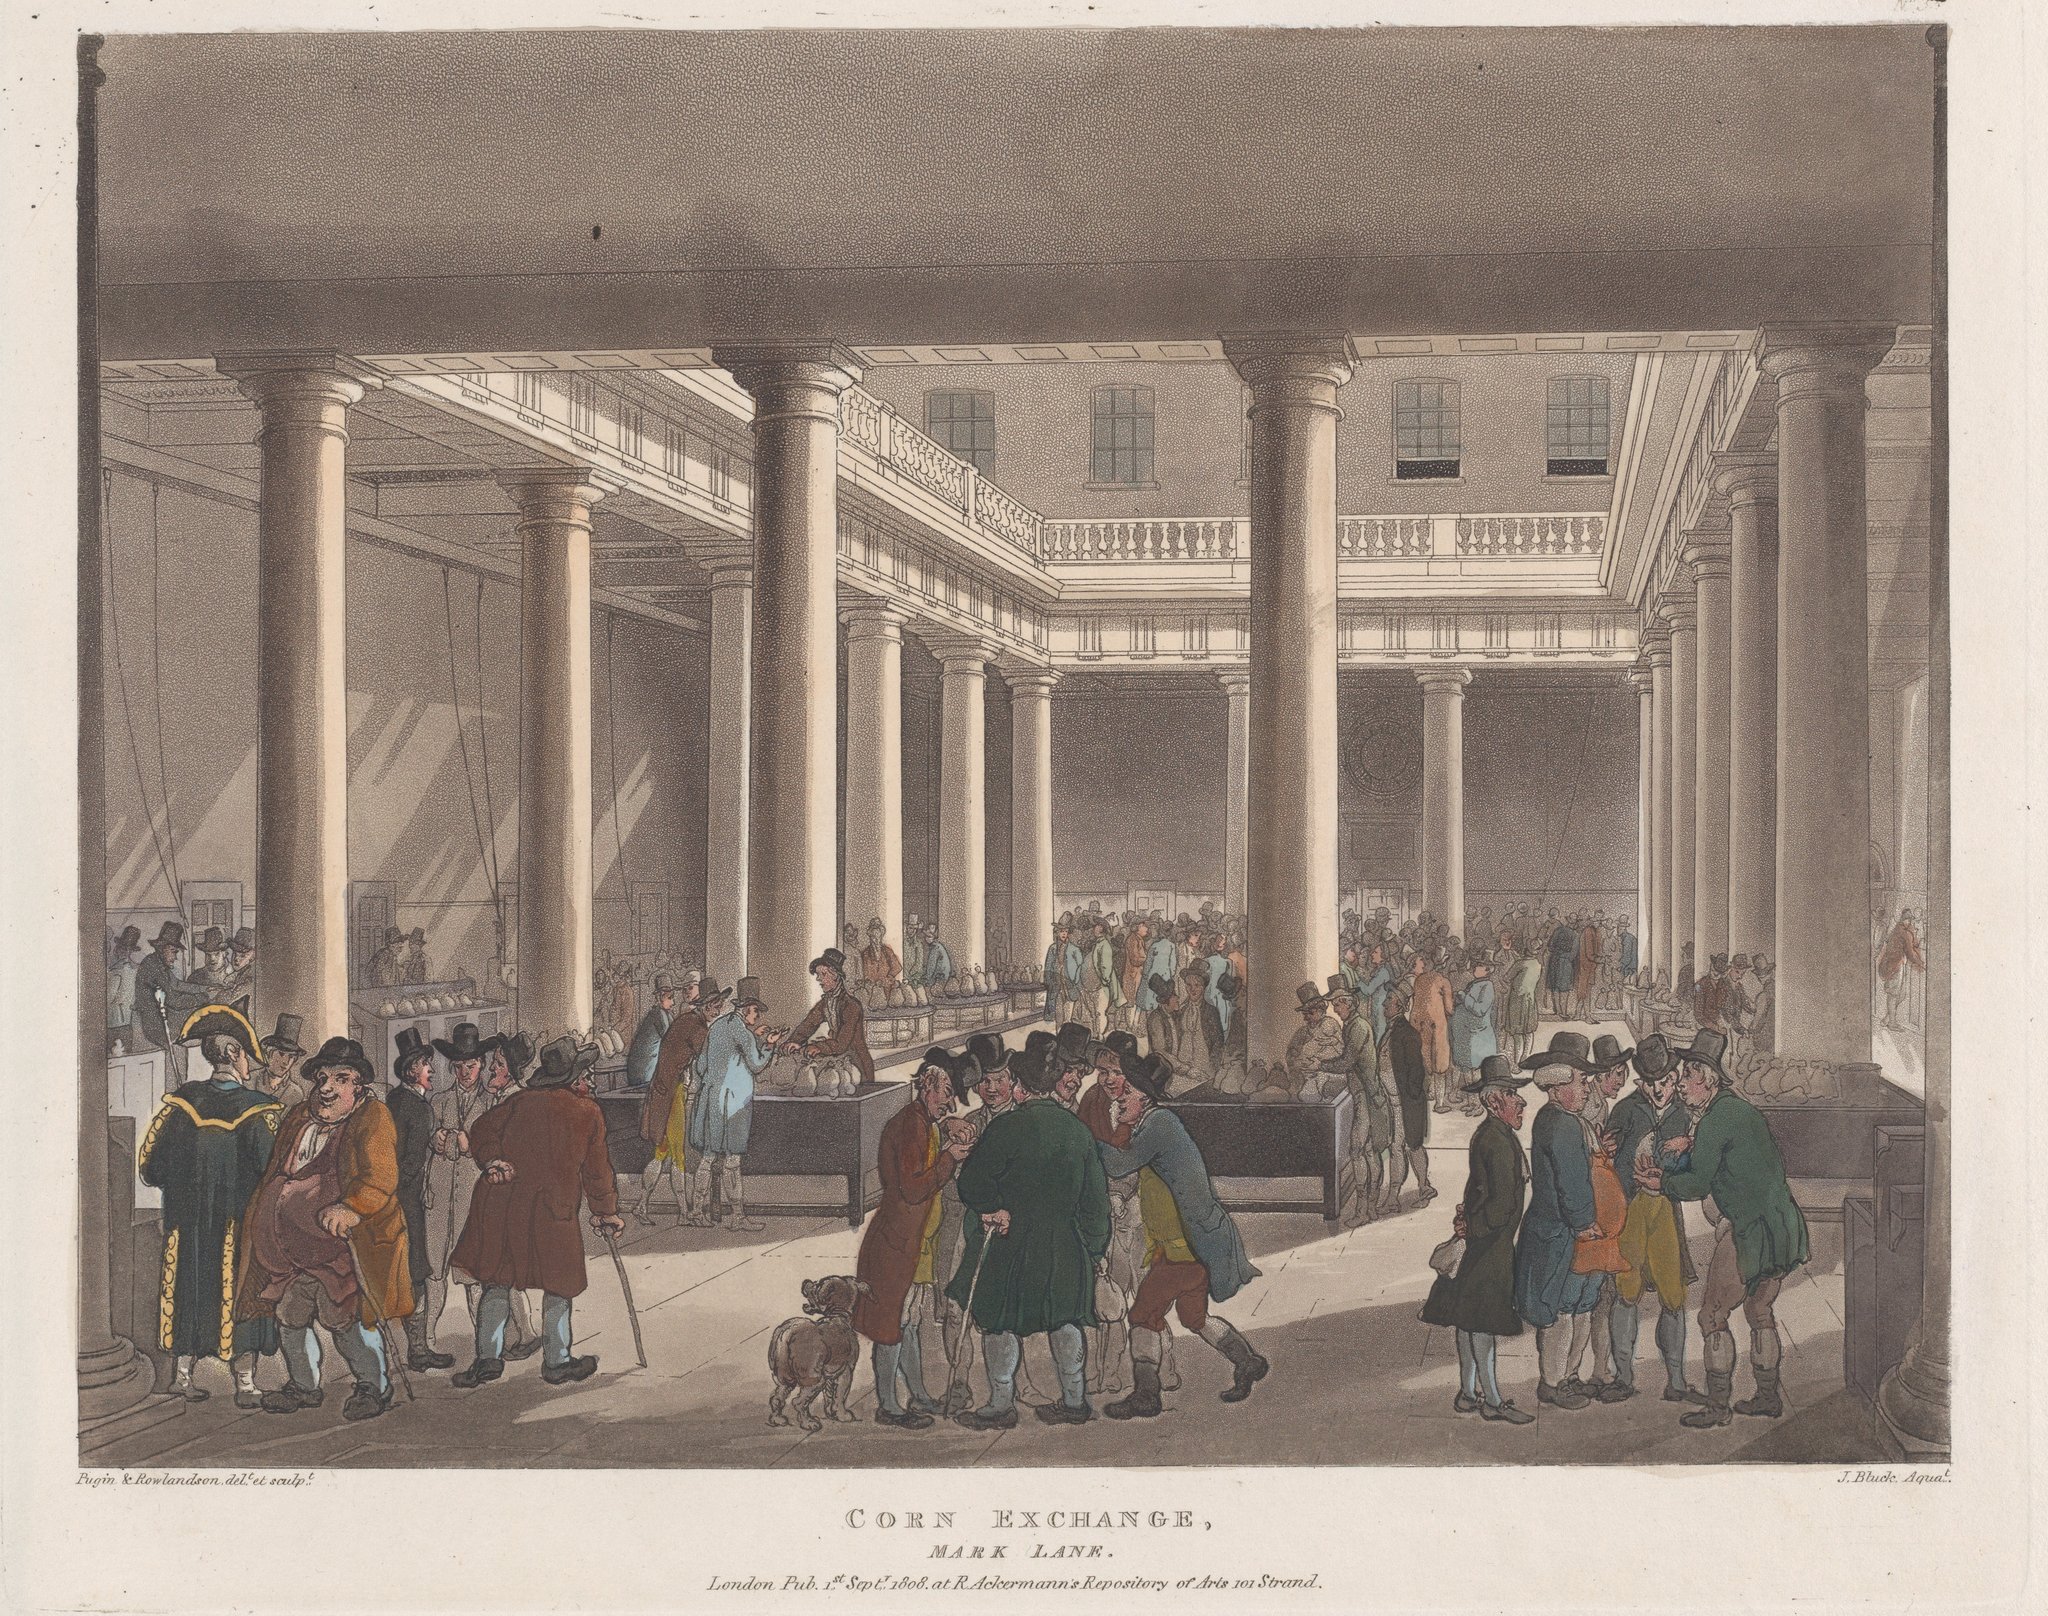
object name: print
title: Corn Exchange, Mark Lane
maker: thomas rowlandson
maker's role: artist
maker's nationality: british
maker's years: 1757-1827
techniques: aquatint, etching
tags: men,dogs,london